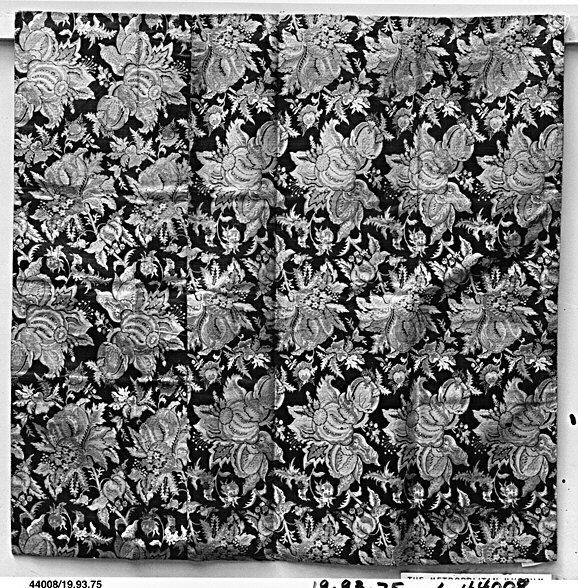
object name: altar cloth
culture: japanese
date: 1615-1868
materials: metal thread, silk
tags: flowers